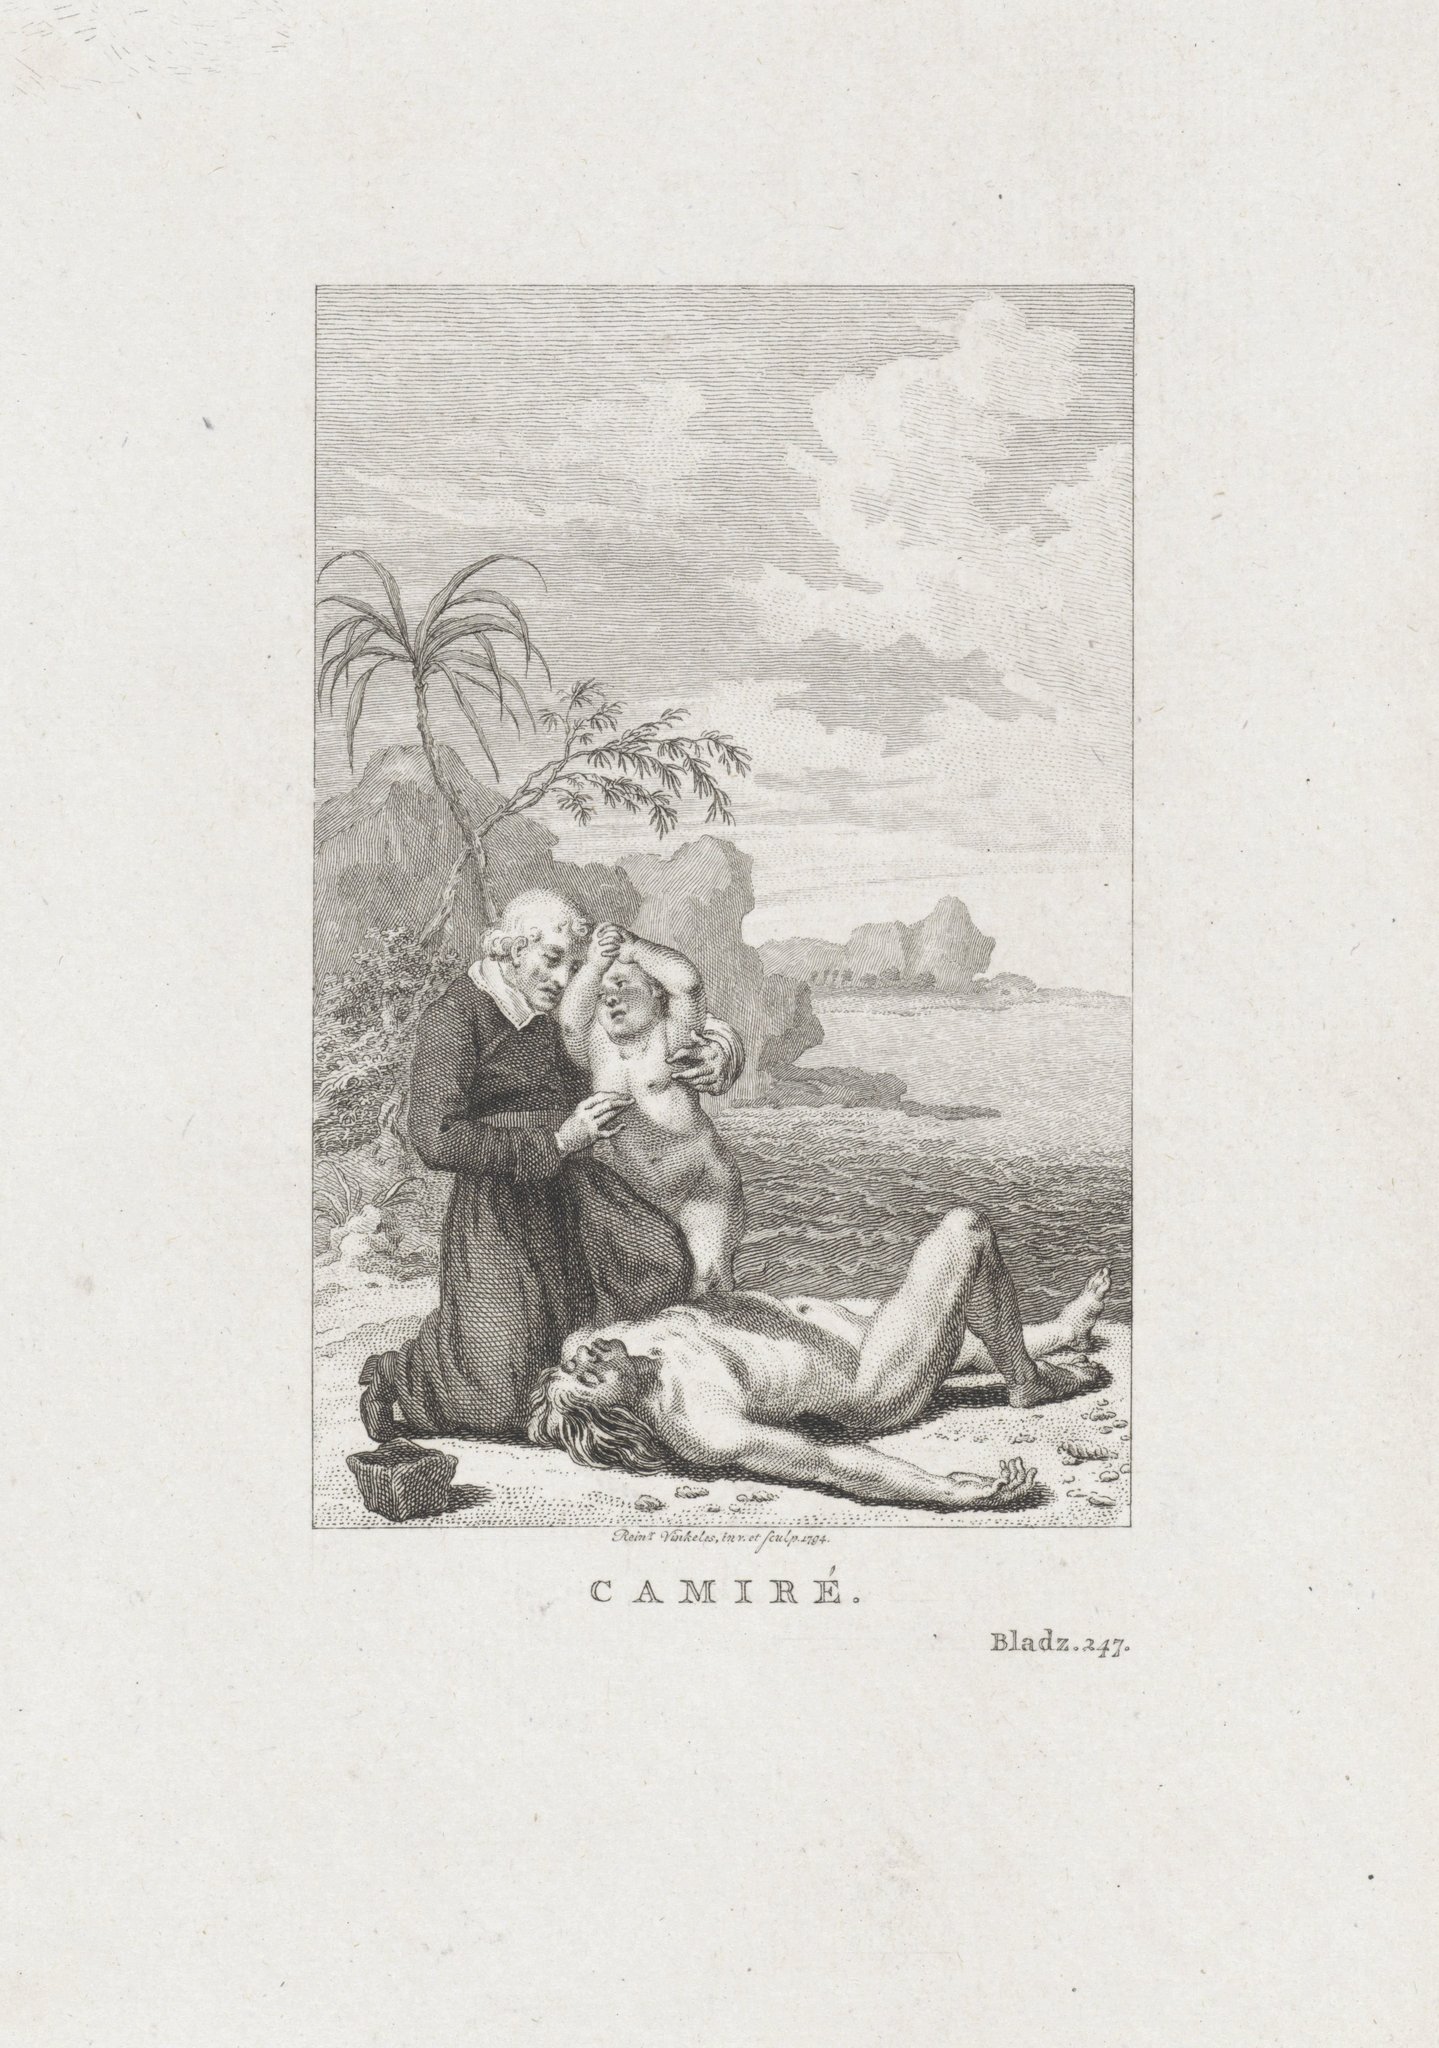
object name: print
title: Geestelijke en een kind bij een dode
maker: reinier vinkeles (i)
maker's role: draughtsman, print maker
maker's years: 1741-1816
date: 1794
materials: paper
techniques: engraving, etching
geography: amsterdam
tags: apparent death, one person praying, beach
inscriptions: collector's mark: Lugt 240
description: Aan de vloedlijn zit een geestelijke met een kind bij een naakte dode man. Illustratie bij het verhaal 'Camiré'.